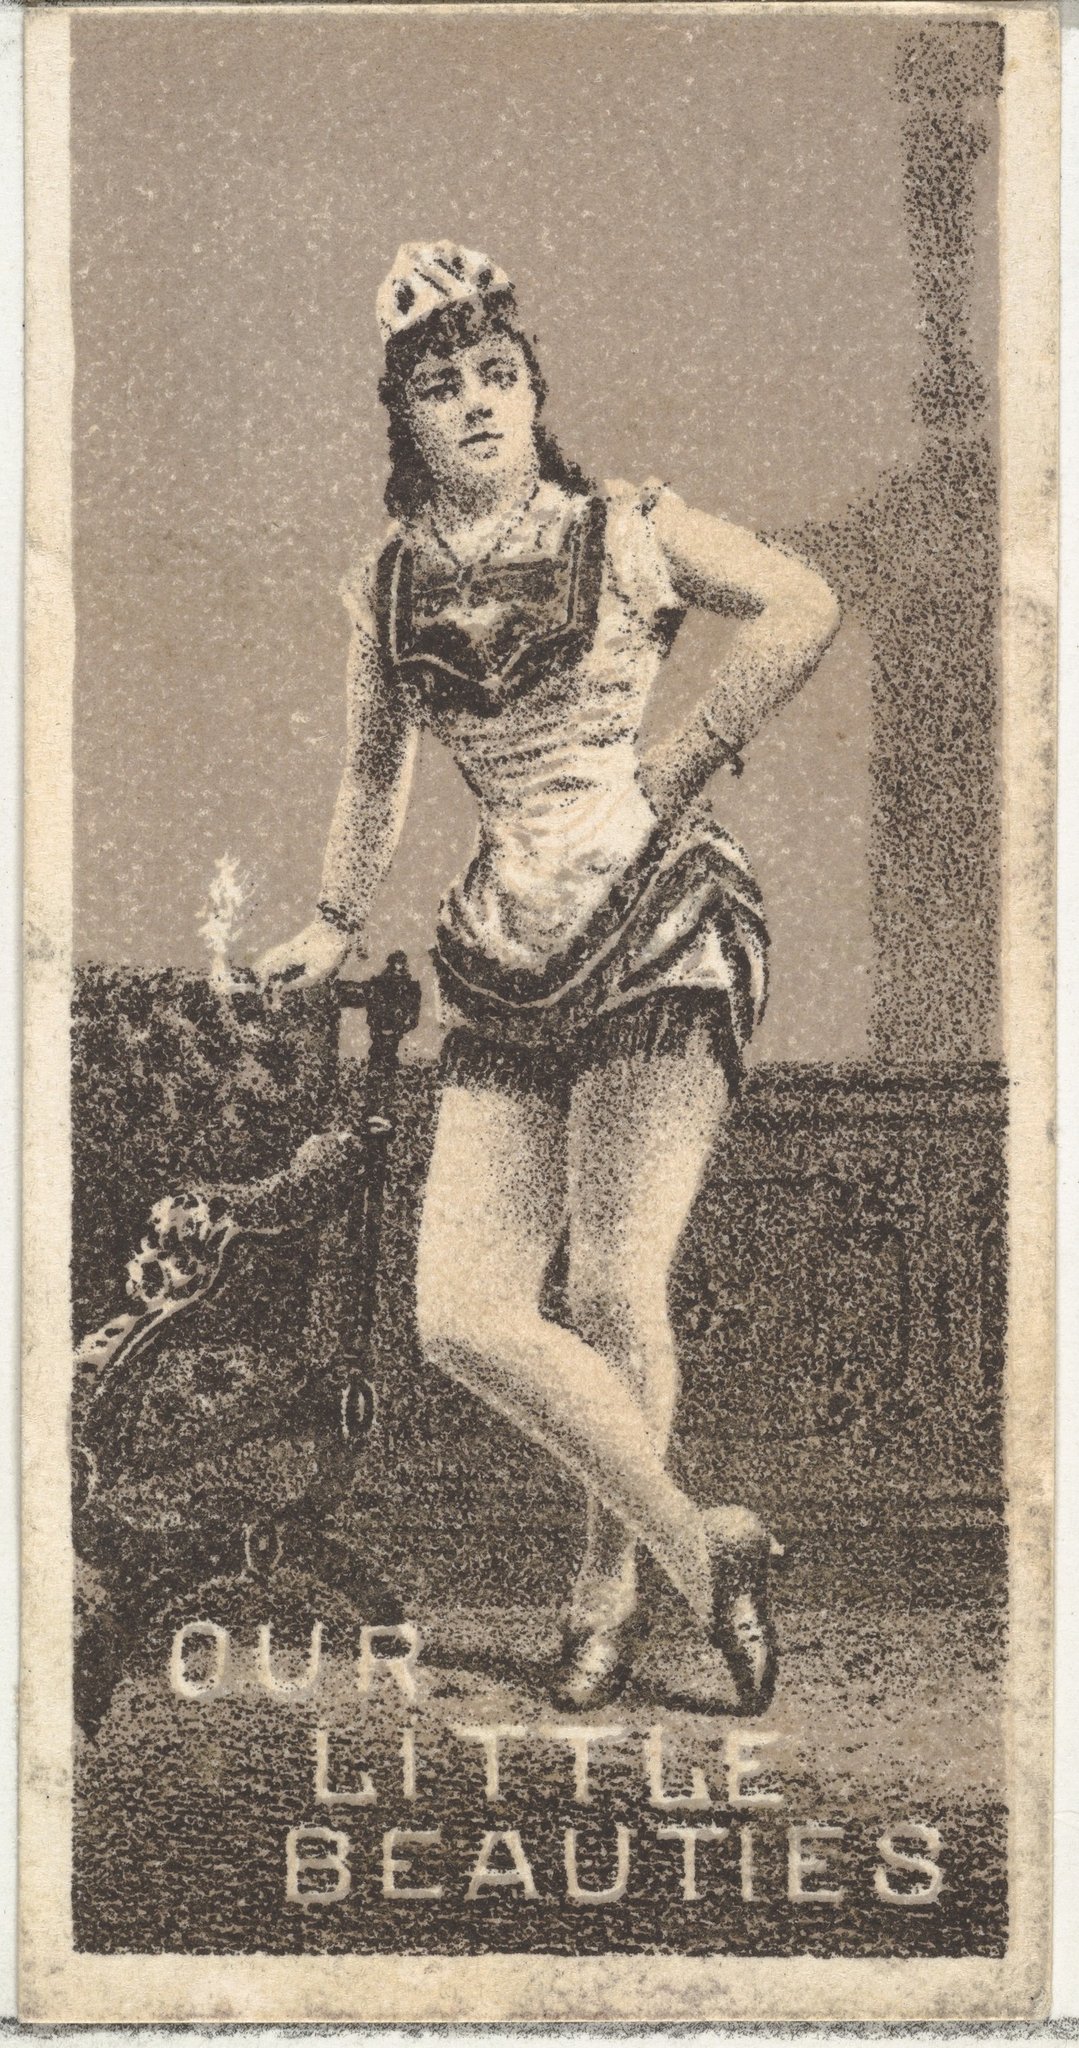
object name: print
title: From the Actresses series (N57) promoting Our Little Beauties Cigarettes for Allen & Ginter brand tobacco products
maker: allen & ginter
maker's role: publisher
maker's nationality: american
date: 1890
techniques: photolithograph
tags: portraits,women,actresses